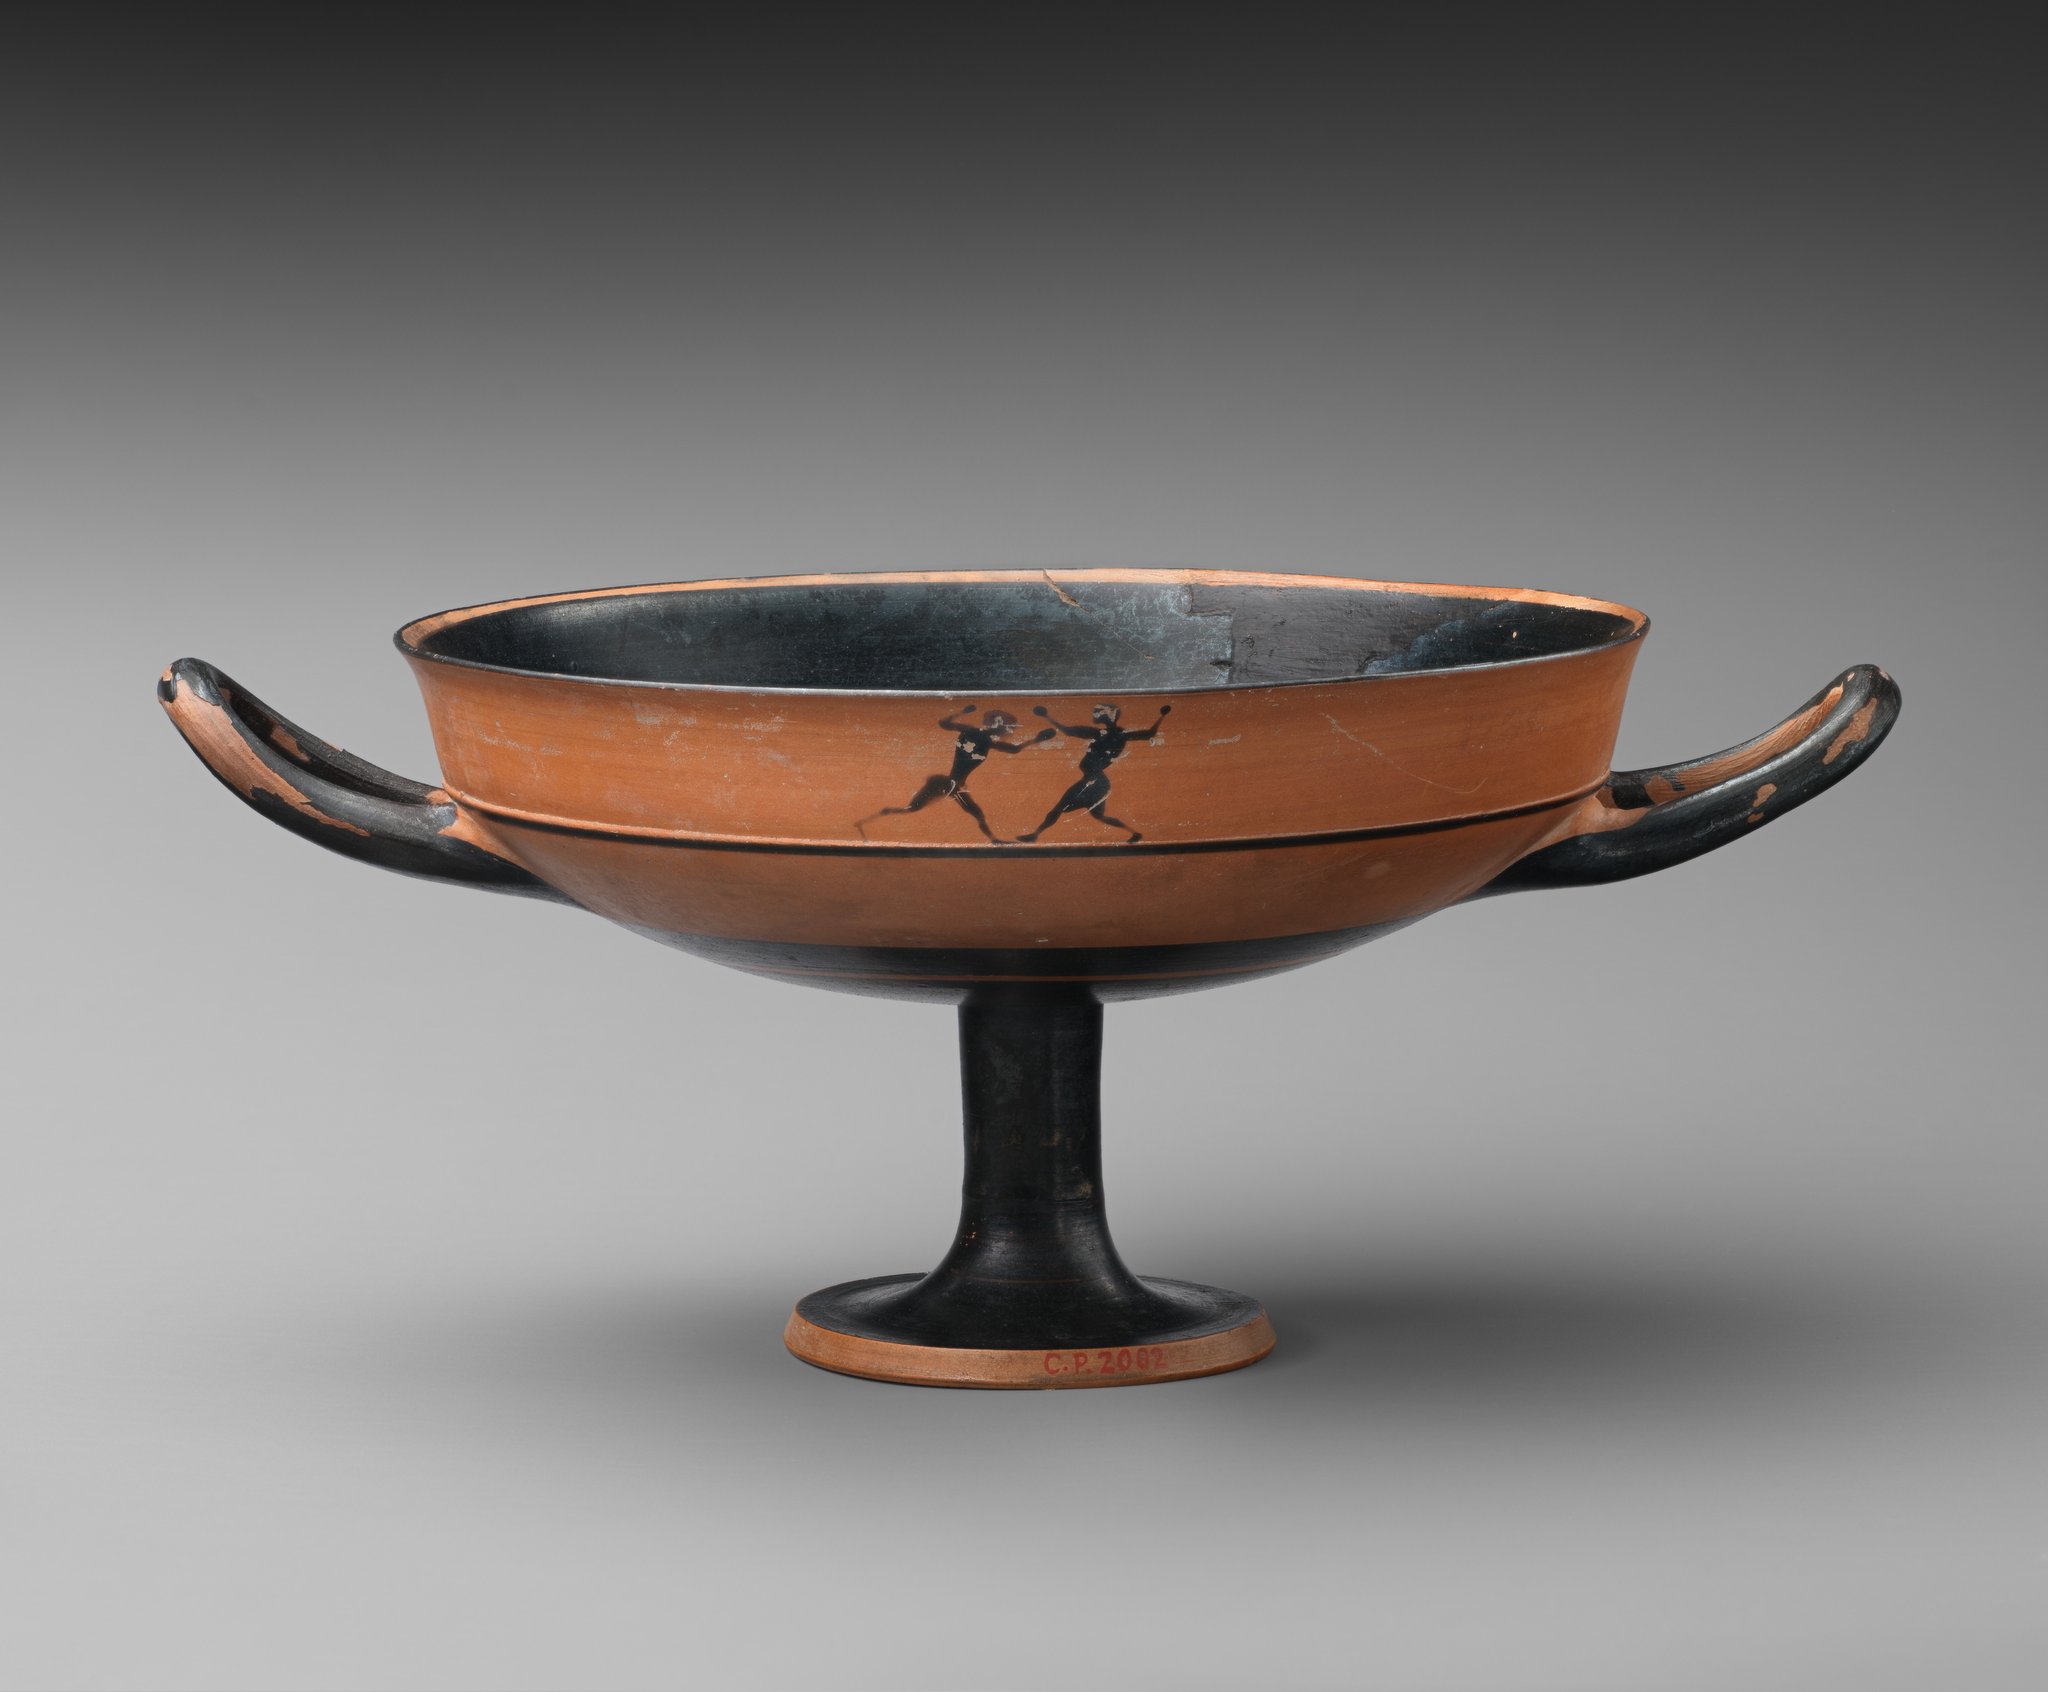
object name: kylix, lip cup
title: Kylix, lip-cup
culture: greek, attic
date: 500 BCE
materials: terracotta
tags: men,boxing